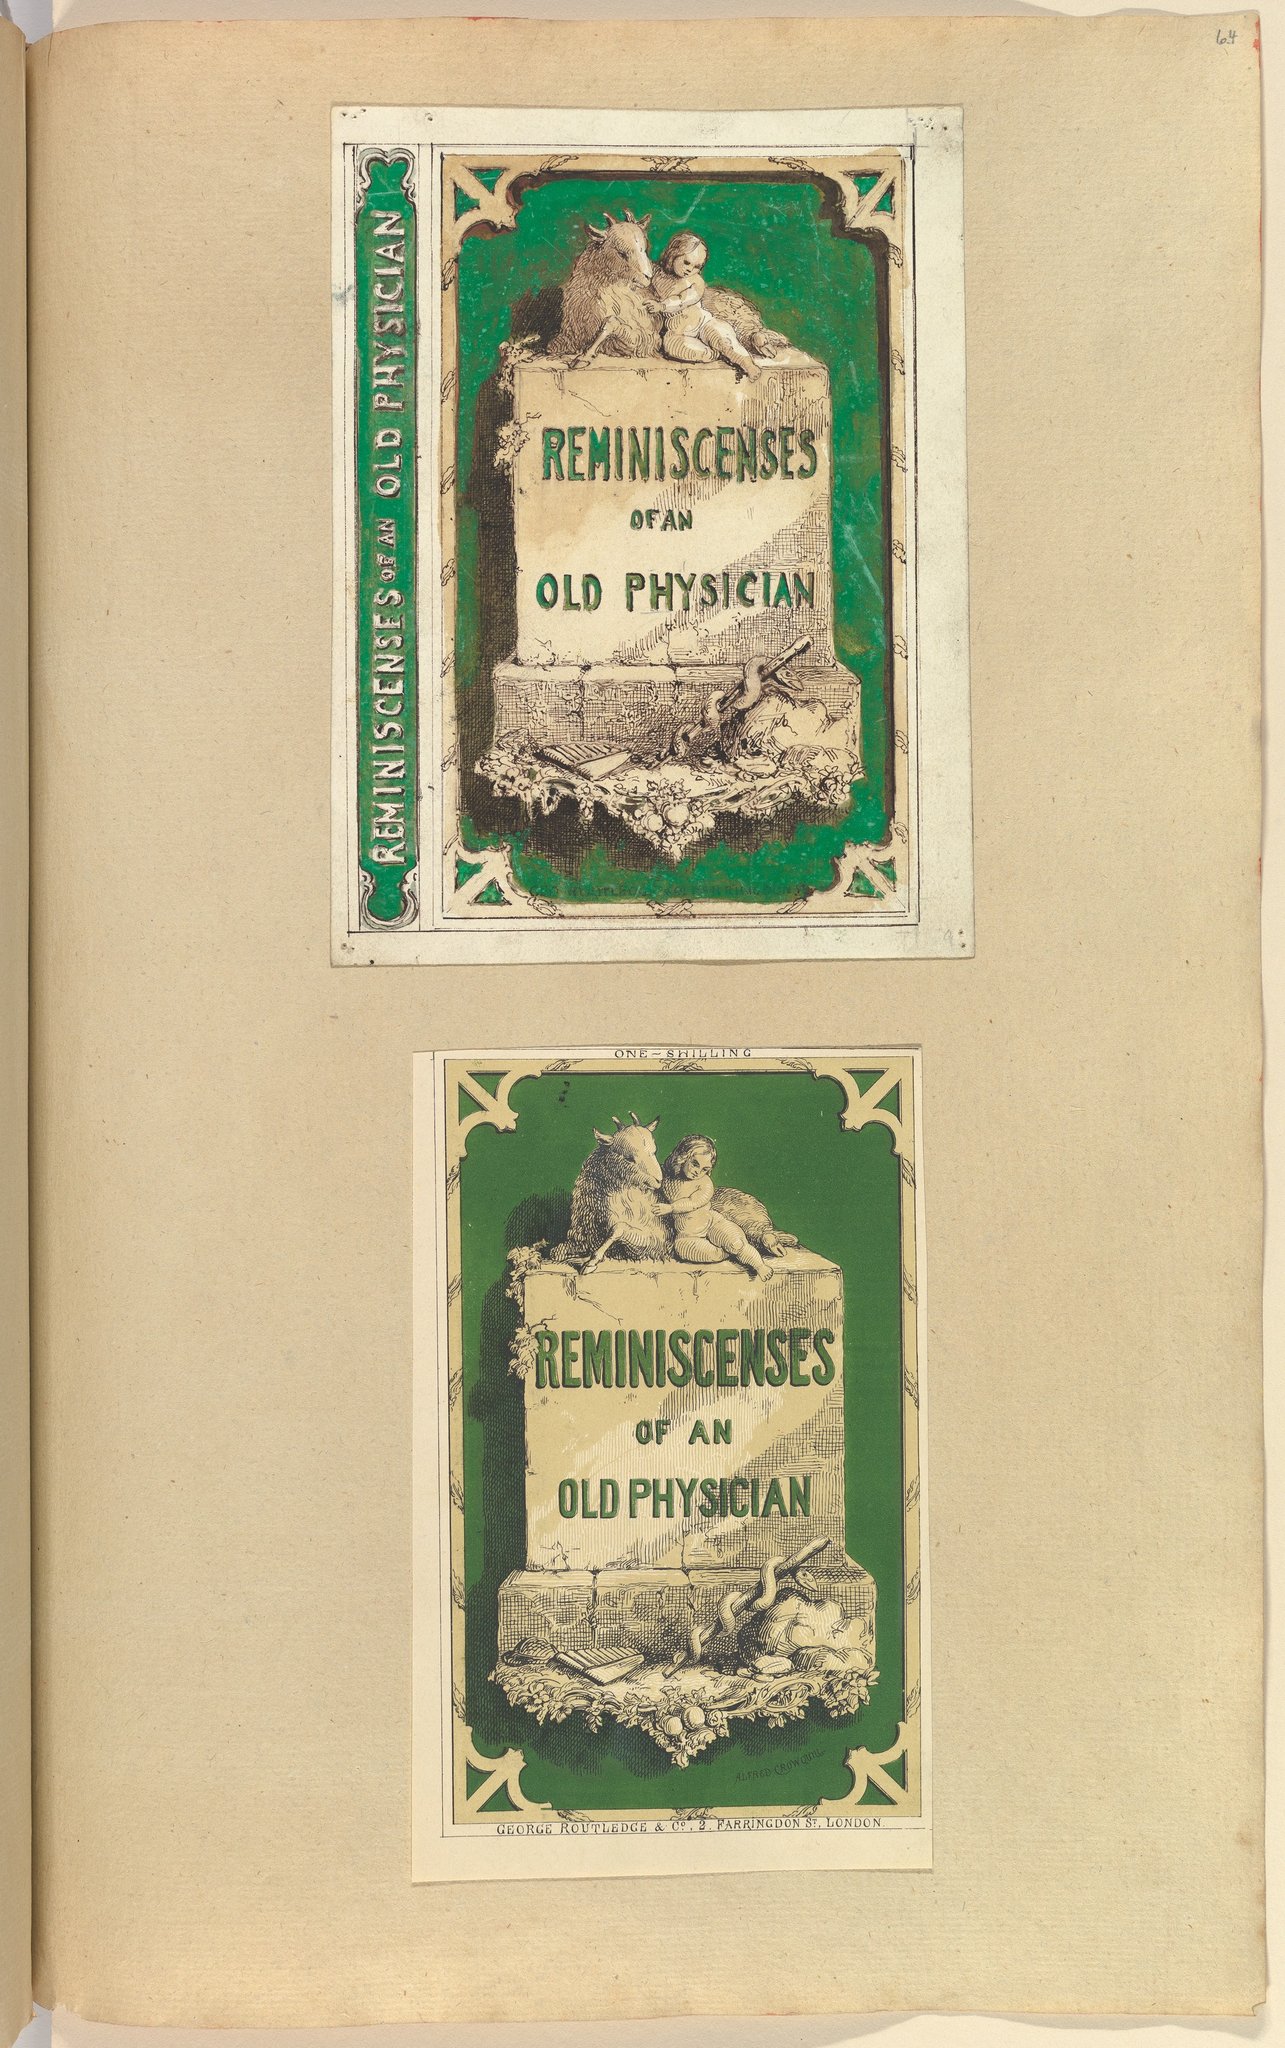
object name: drawing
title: Design and Proof for Bookcover, Reminiscenses of an Old Physician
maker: alfred henry forrester [alfred crowquill]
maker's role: artist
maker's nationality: british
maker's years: 1804-1872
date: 1845-1870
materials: gouache, ink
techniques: pen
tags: children,sheep